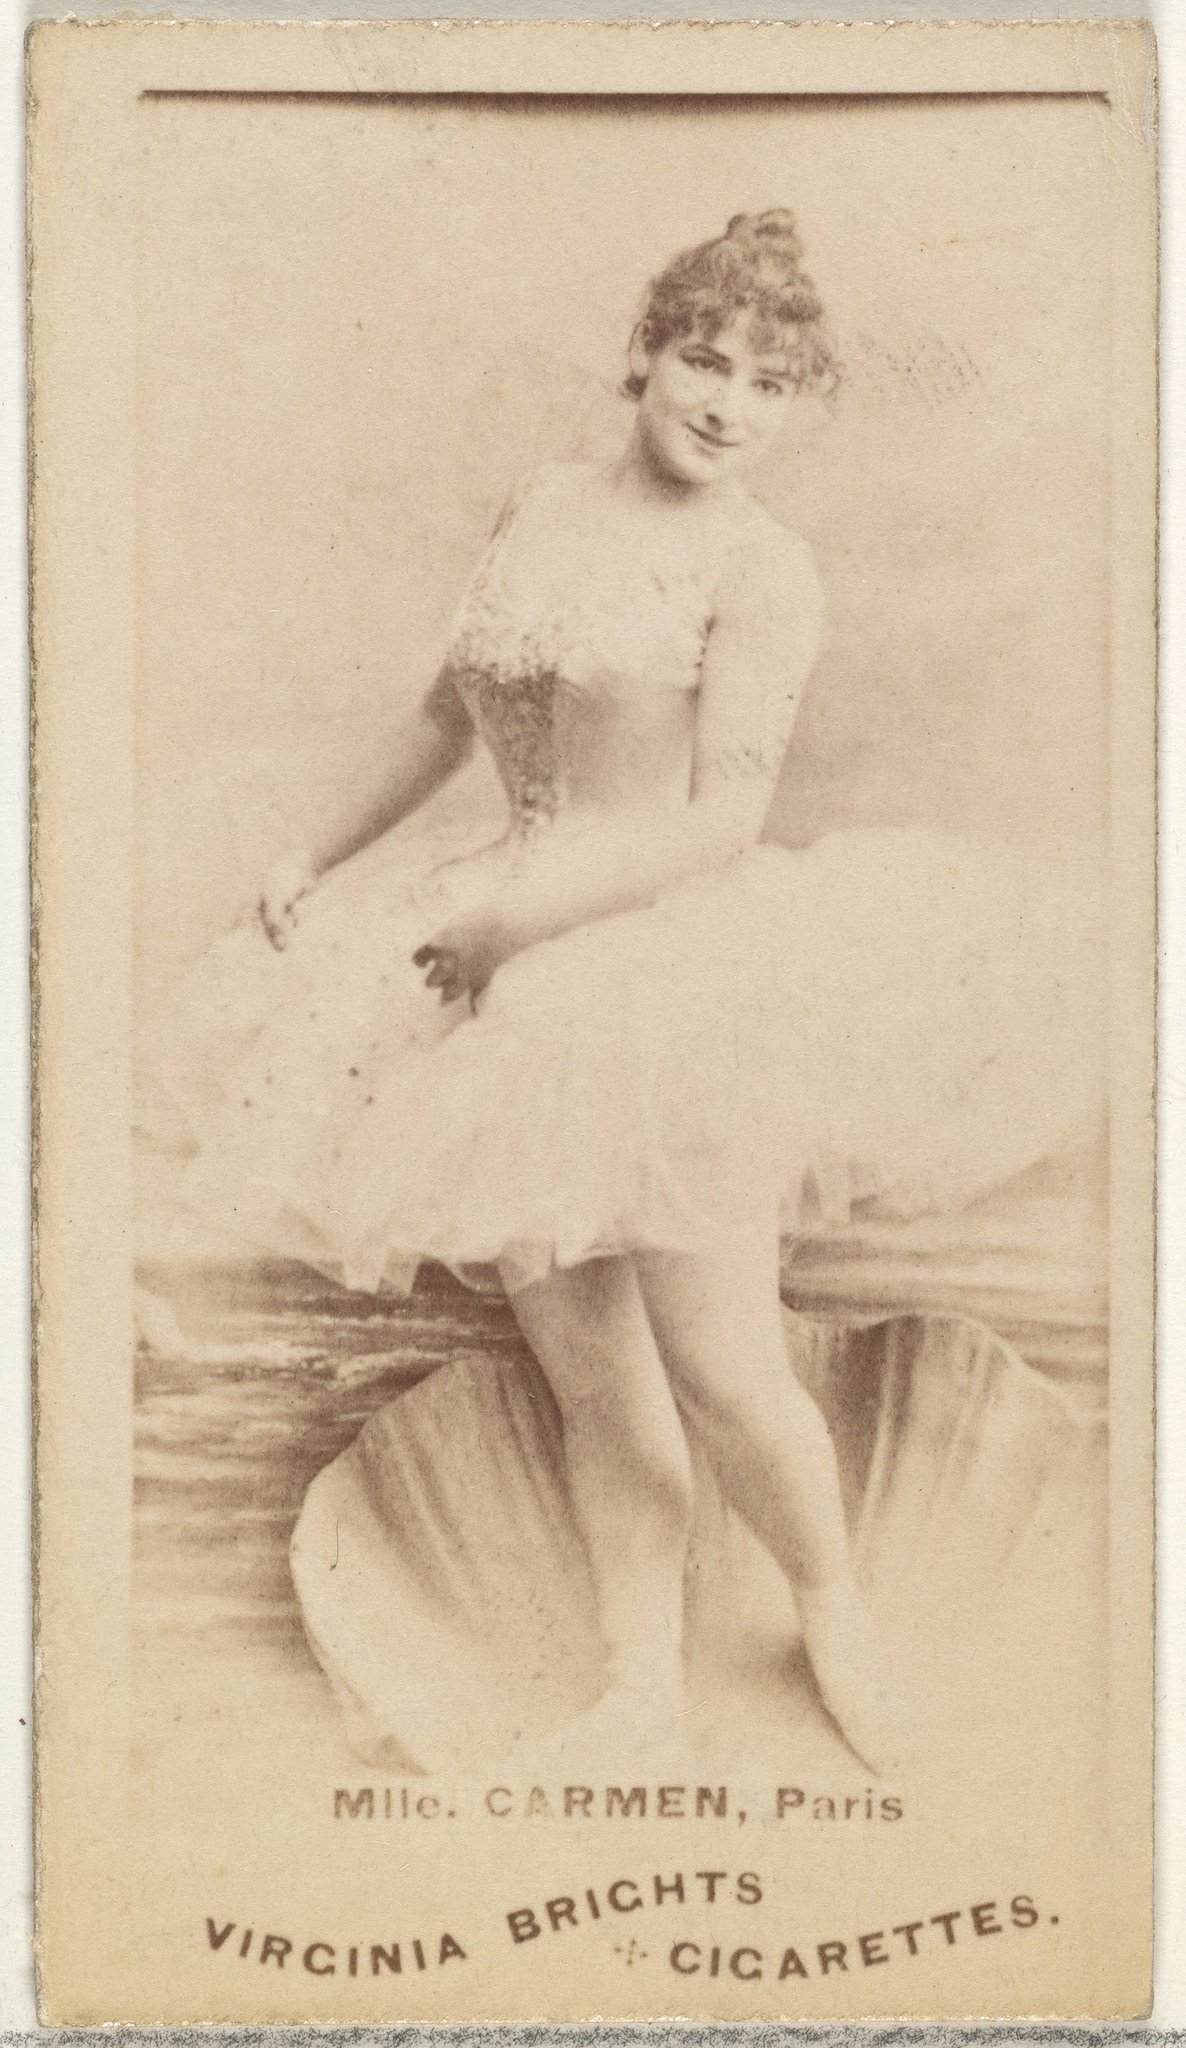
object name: photograph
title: Mlle. Carmen, Paris, from the Actors and Actresses series (N45, Type 1) for Virginia Brights Cigarettes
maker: allen & ginter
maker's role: publisher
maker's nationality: american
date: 1888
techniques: albumen silver print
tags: portraits,women,actresses